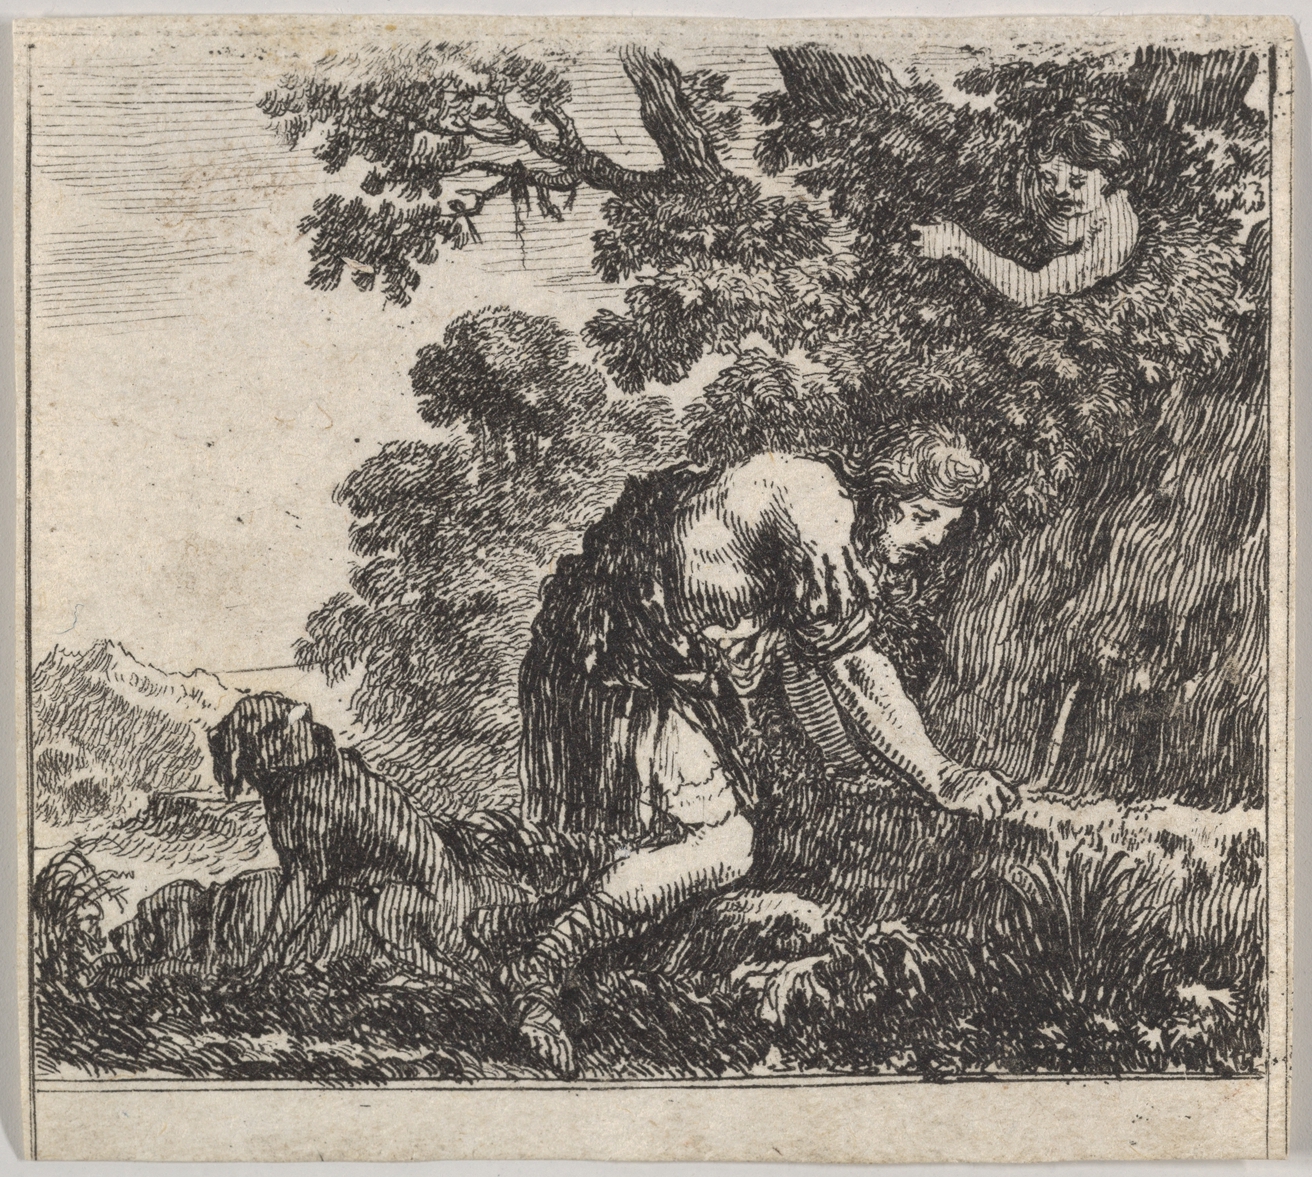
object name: print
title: Narcissus, from "Game of Mythology" (Jeu de la Mythologie)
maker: stefano della bella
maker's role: artist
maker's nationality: italian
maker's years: 1610-1664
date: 1644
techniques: etching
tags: human figures,animals,narcissus,trees